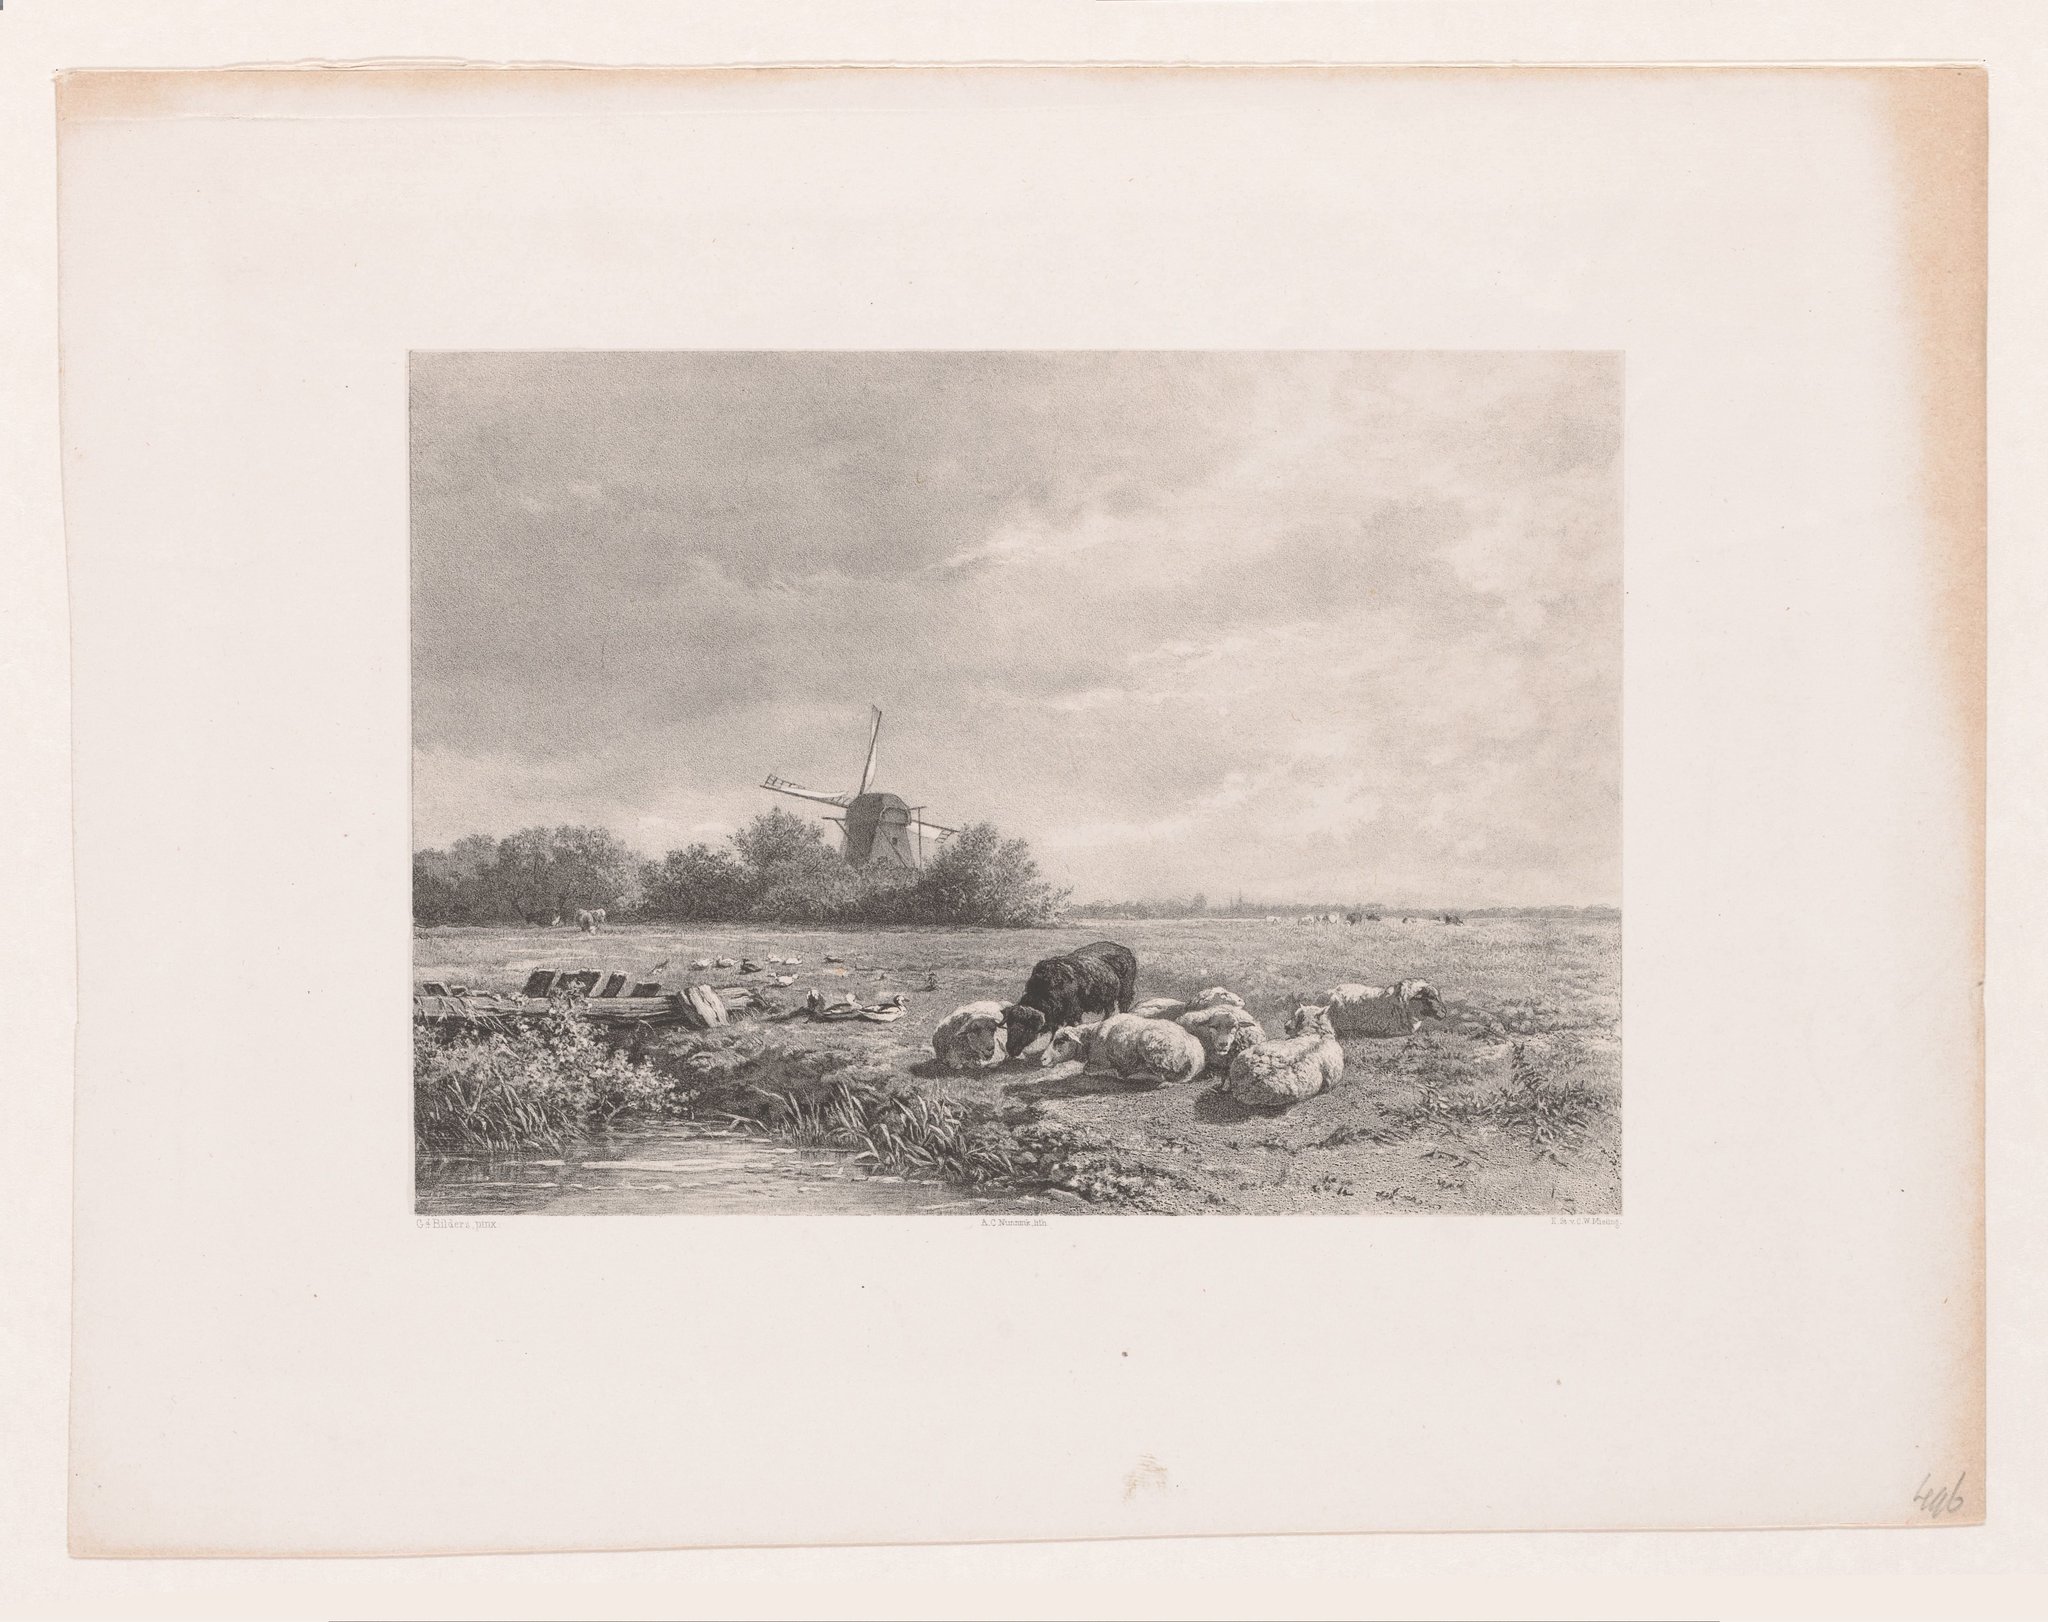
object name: print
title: Ram en schapen in een wei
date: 1848-1865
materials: paper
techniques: lithograph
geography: the hague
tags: sheep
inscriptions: collector's mark: Lugt 2228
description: Een ram en zes schapen in een wei naast een plas. In de achtergrond nog meer schapen in de wei en een molen.